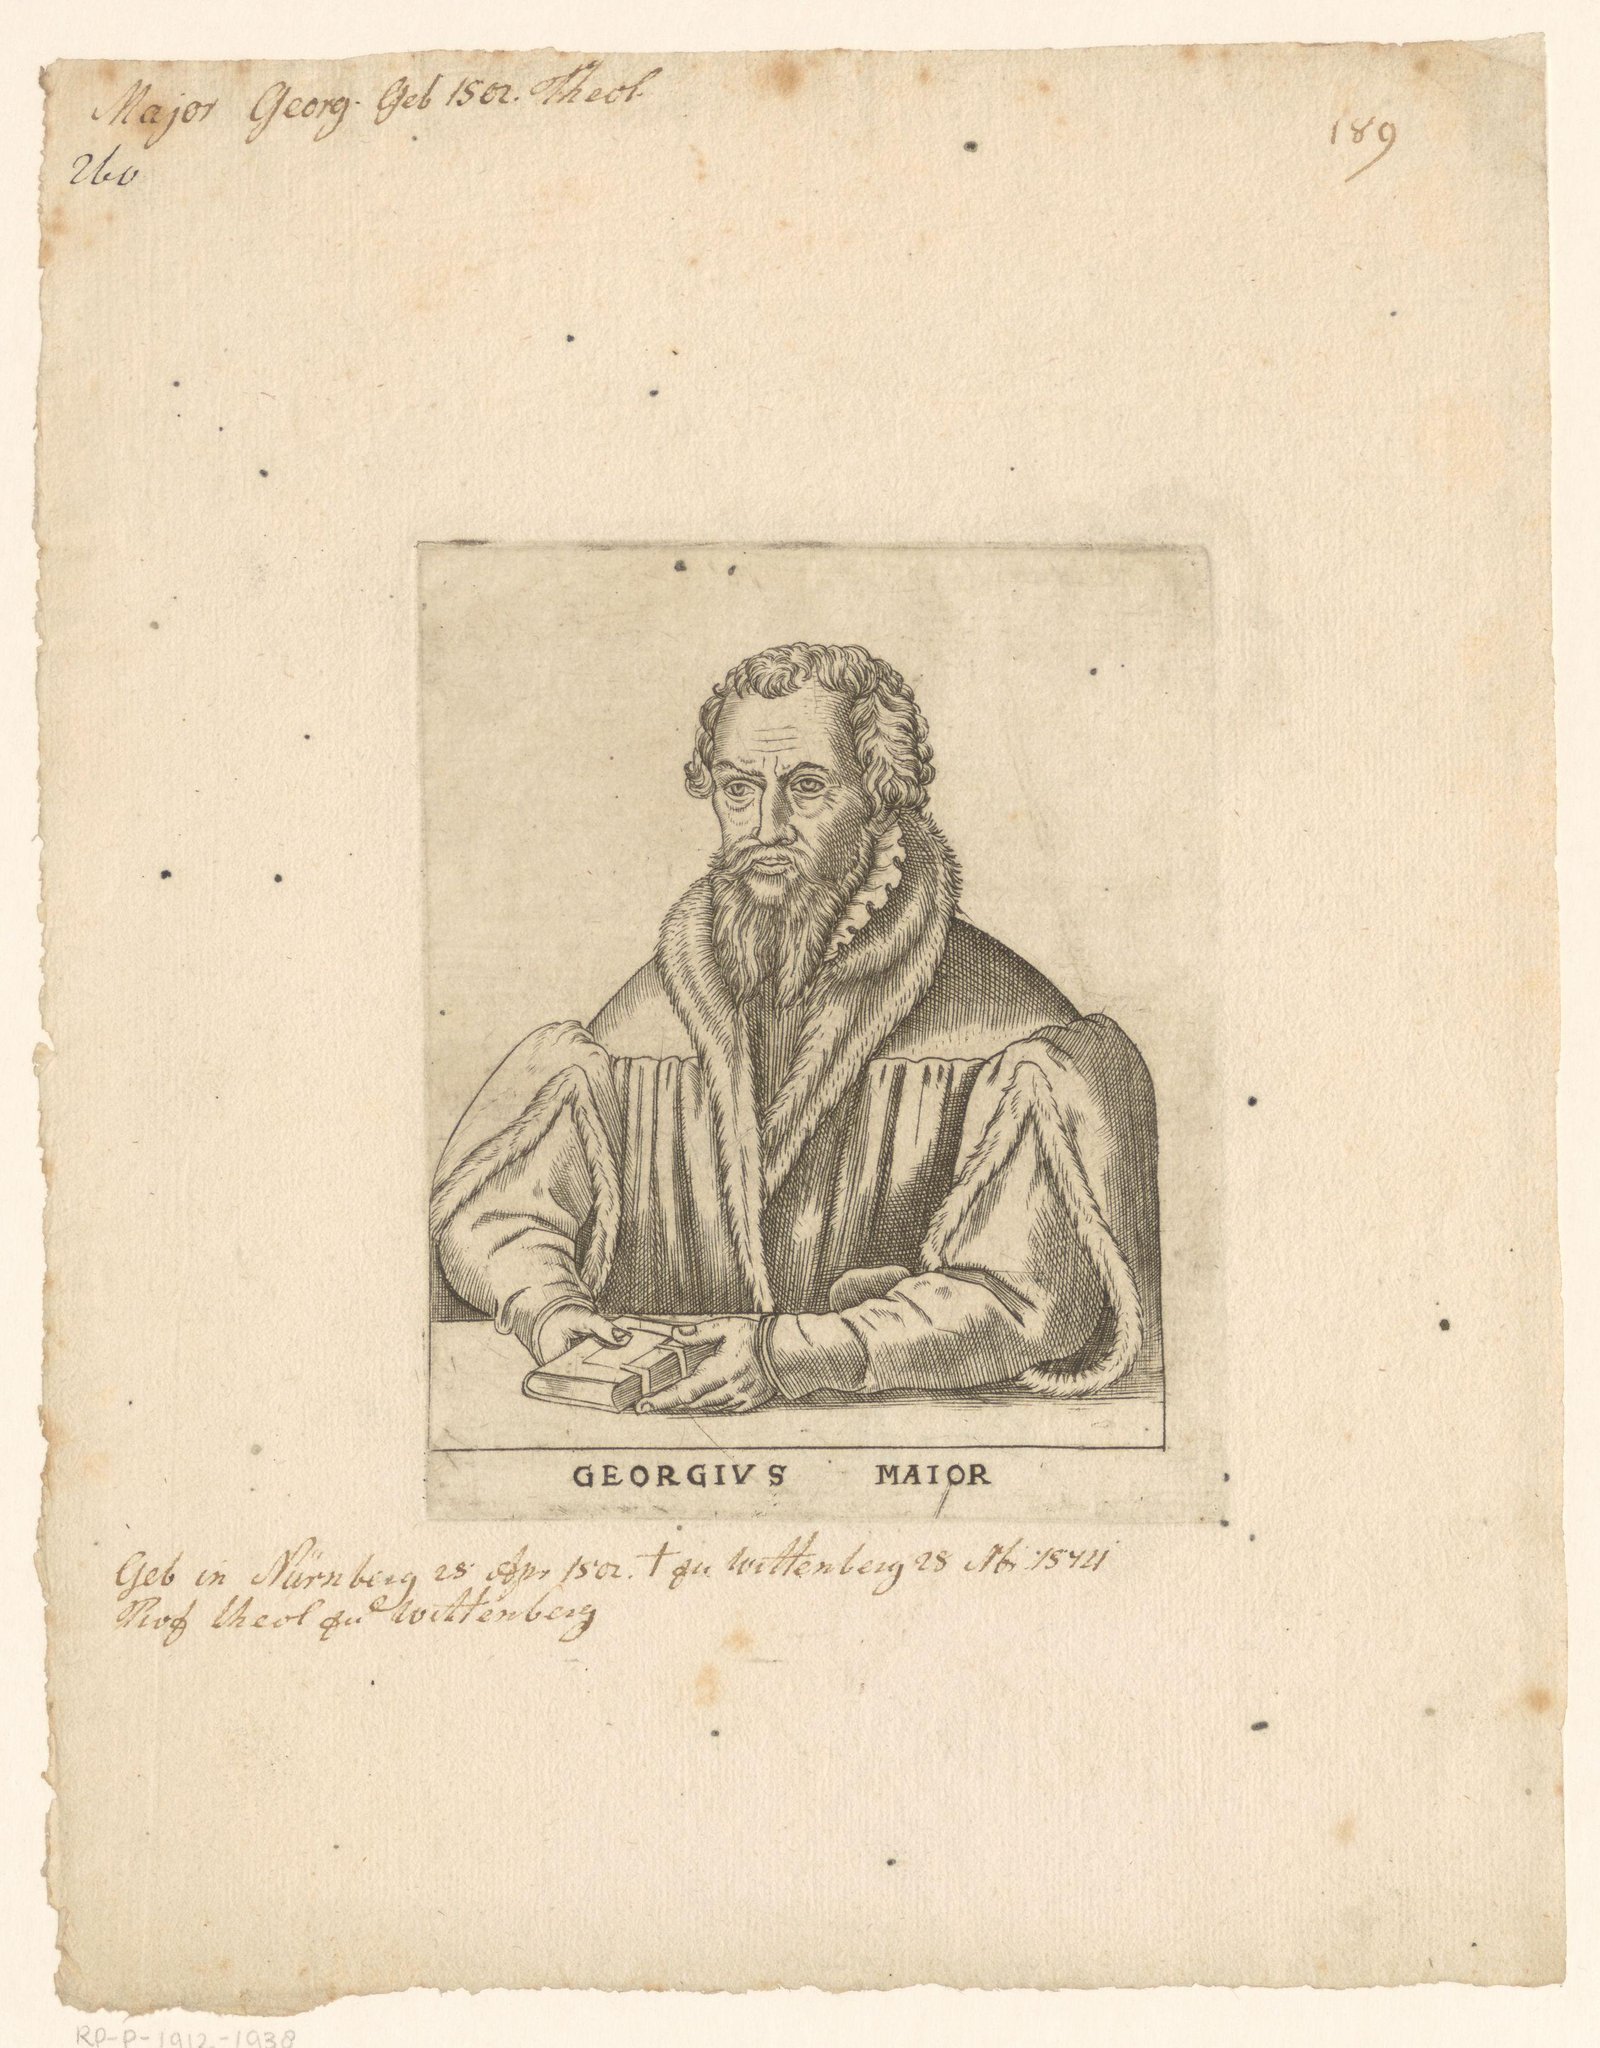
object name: print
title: Portret van Georg Major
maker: Anonymous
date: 1563-1642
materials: paper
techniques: engraving, etching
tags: theologian, historical persons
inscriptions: collector's mark: Lugt 2228, number: ‘189’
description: Deze prent (een impressie) hoort bij een serie portretten van sturende personen tijdens de reformatie.